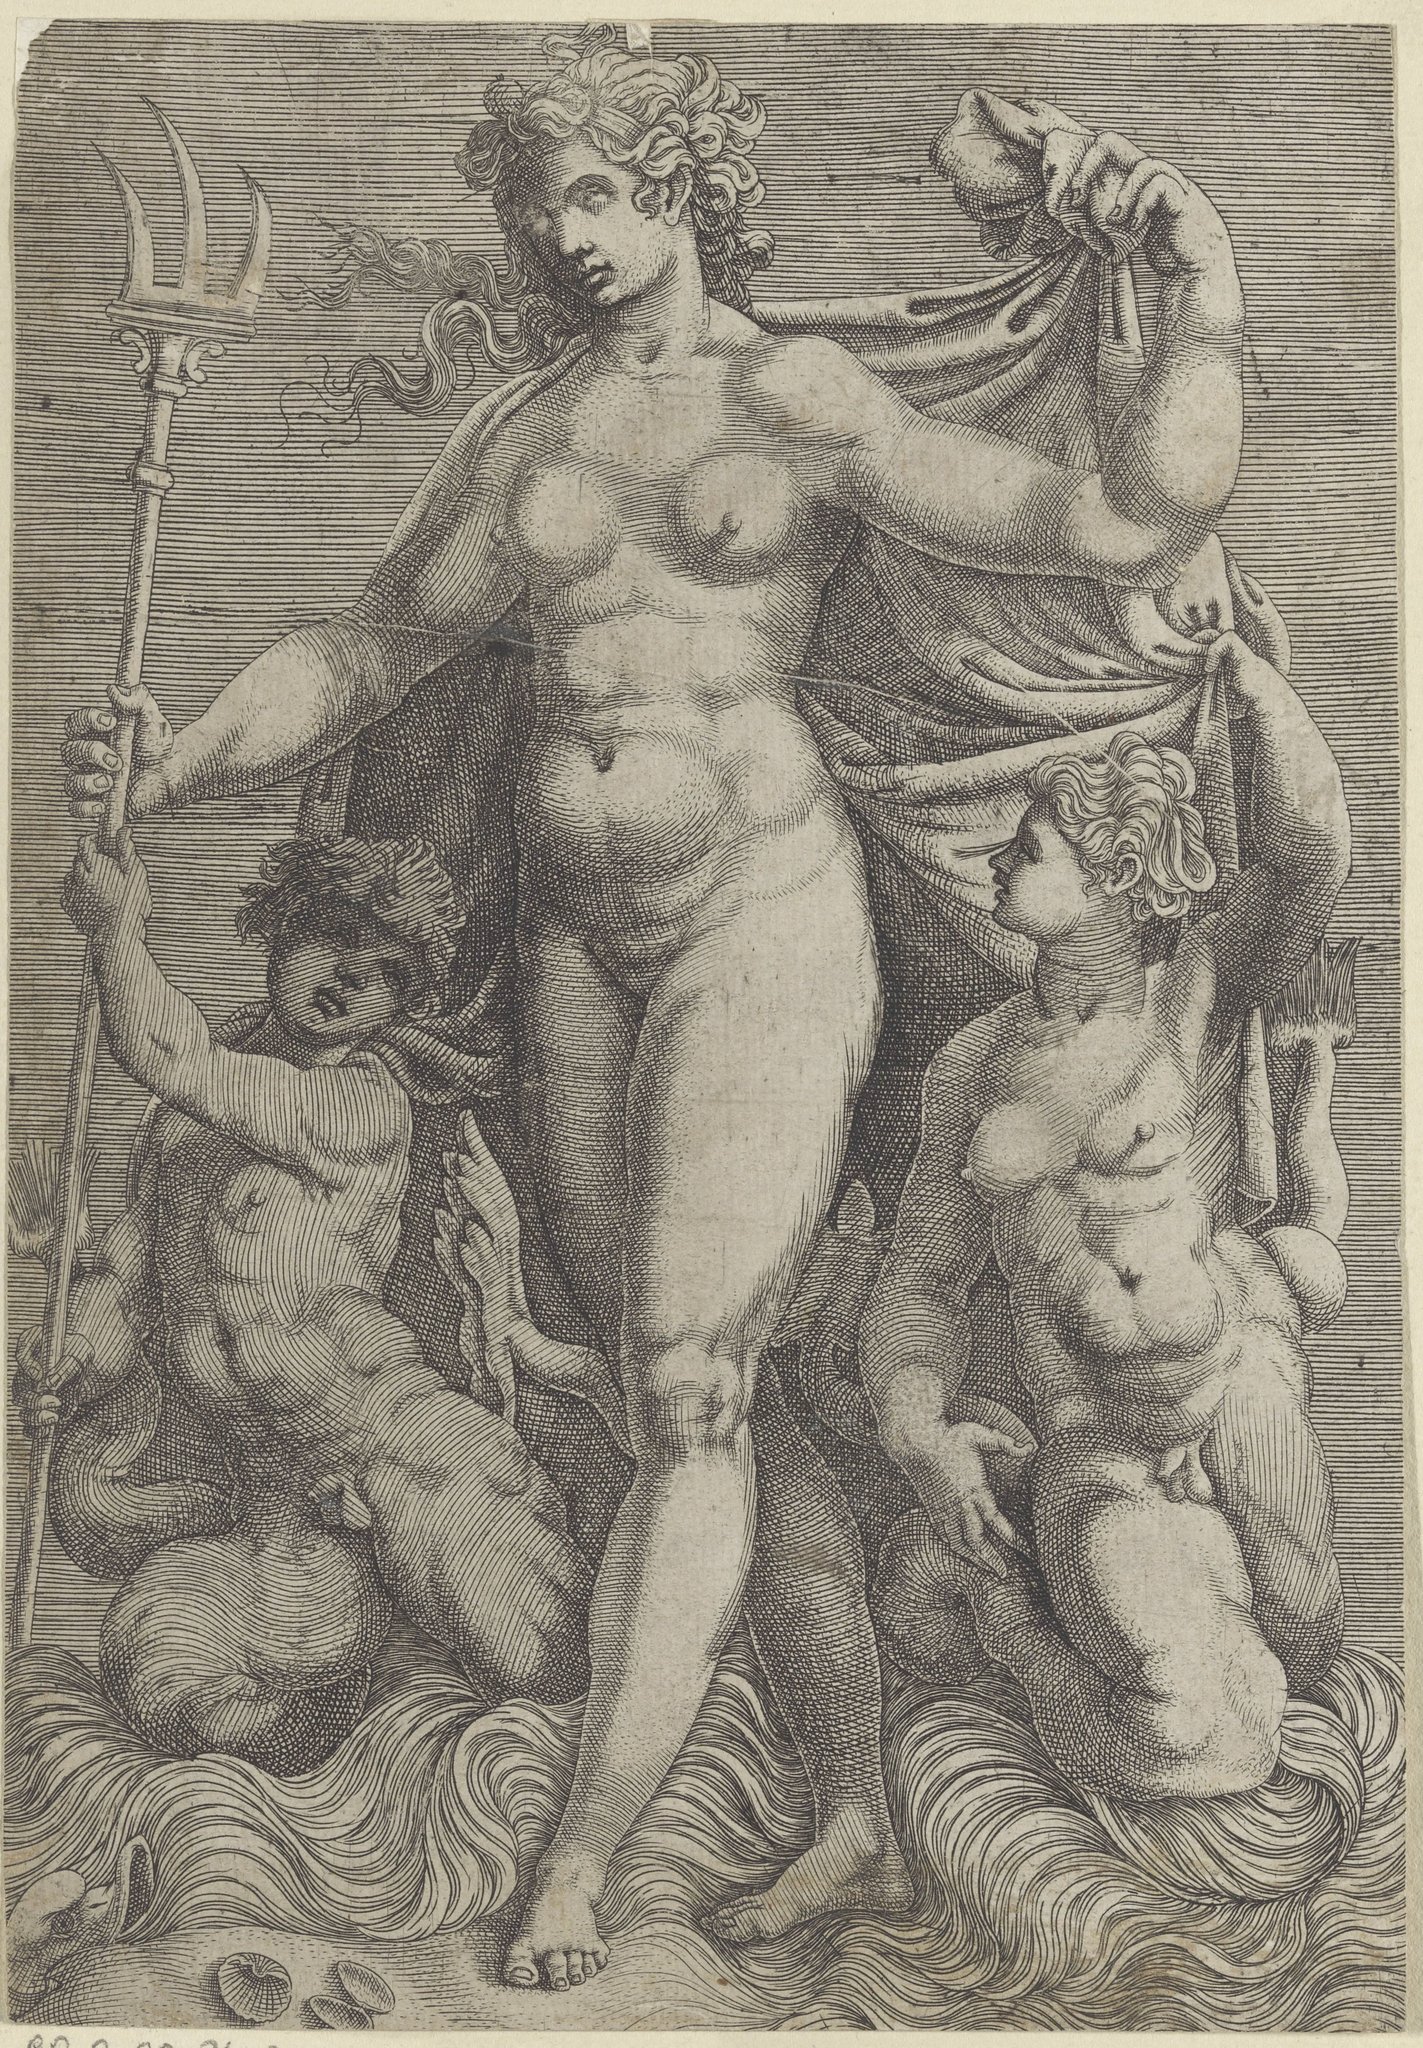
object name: print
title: Thetis met twee tritons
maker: Anonymous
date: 1511-1611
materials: paper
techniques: engraving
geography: italy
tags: (story of) thetis; 'thethi, ninfa del mare' (ripa)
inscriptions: collector's mark: Lugt 240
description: De zeenimf Thetis met een drietand en twee tritons.